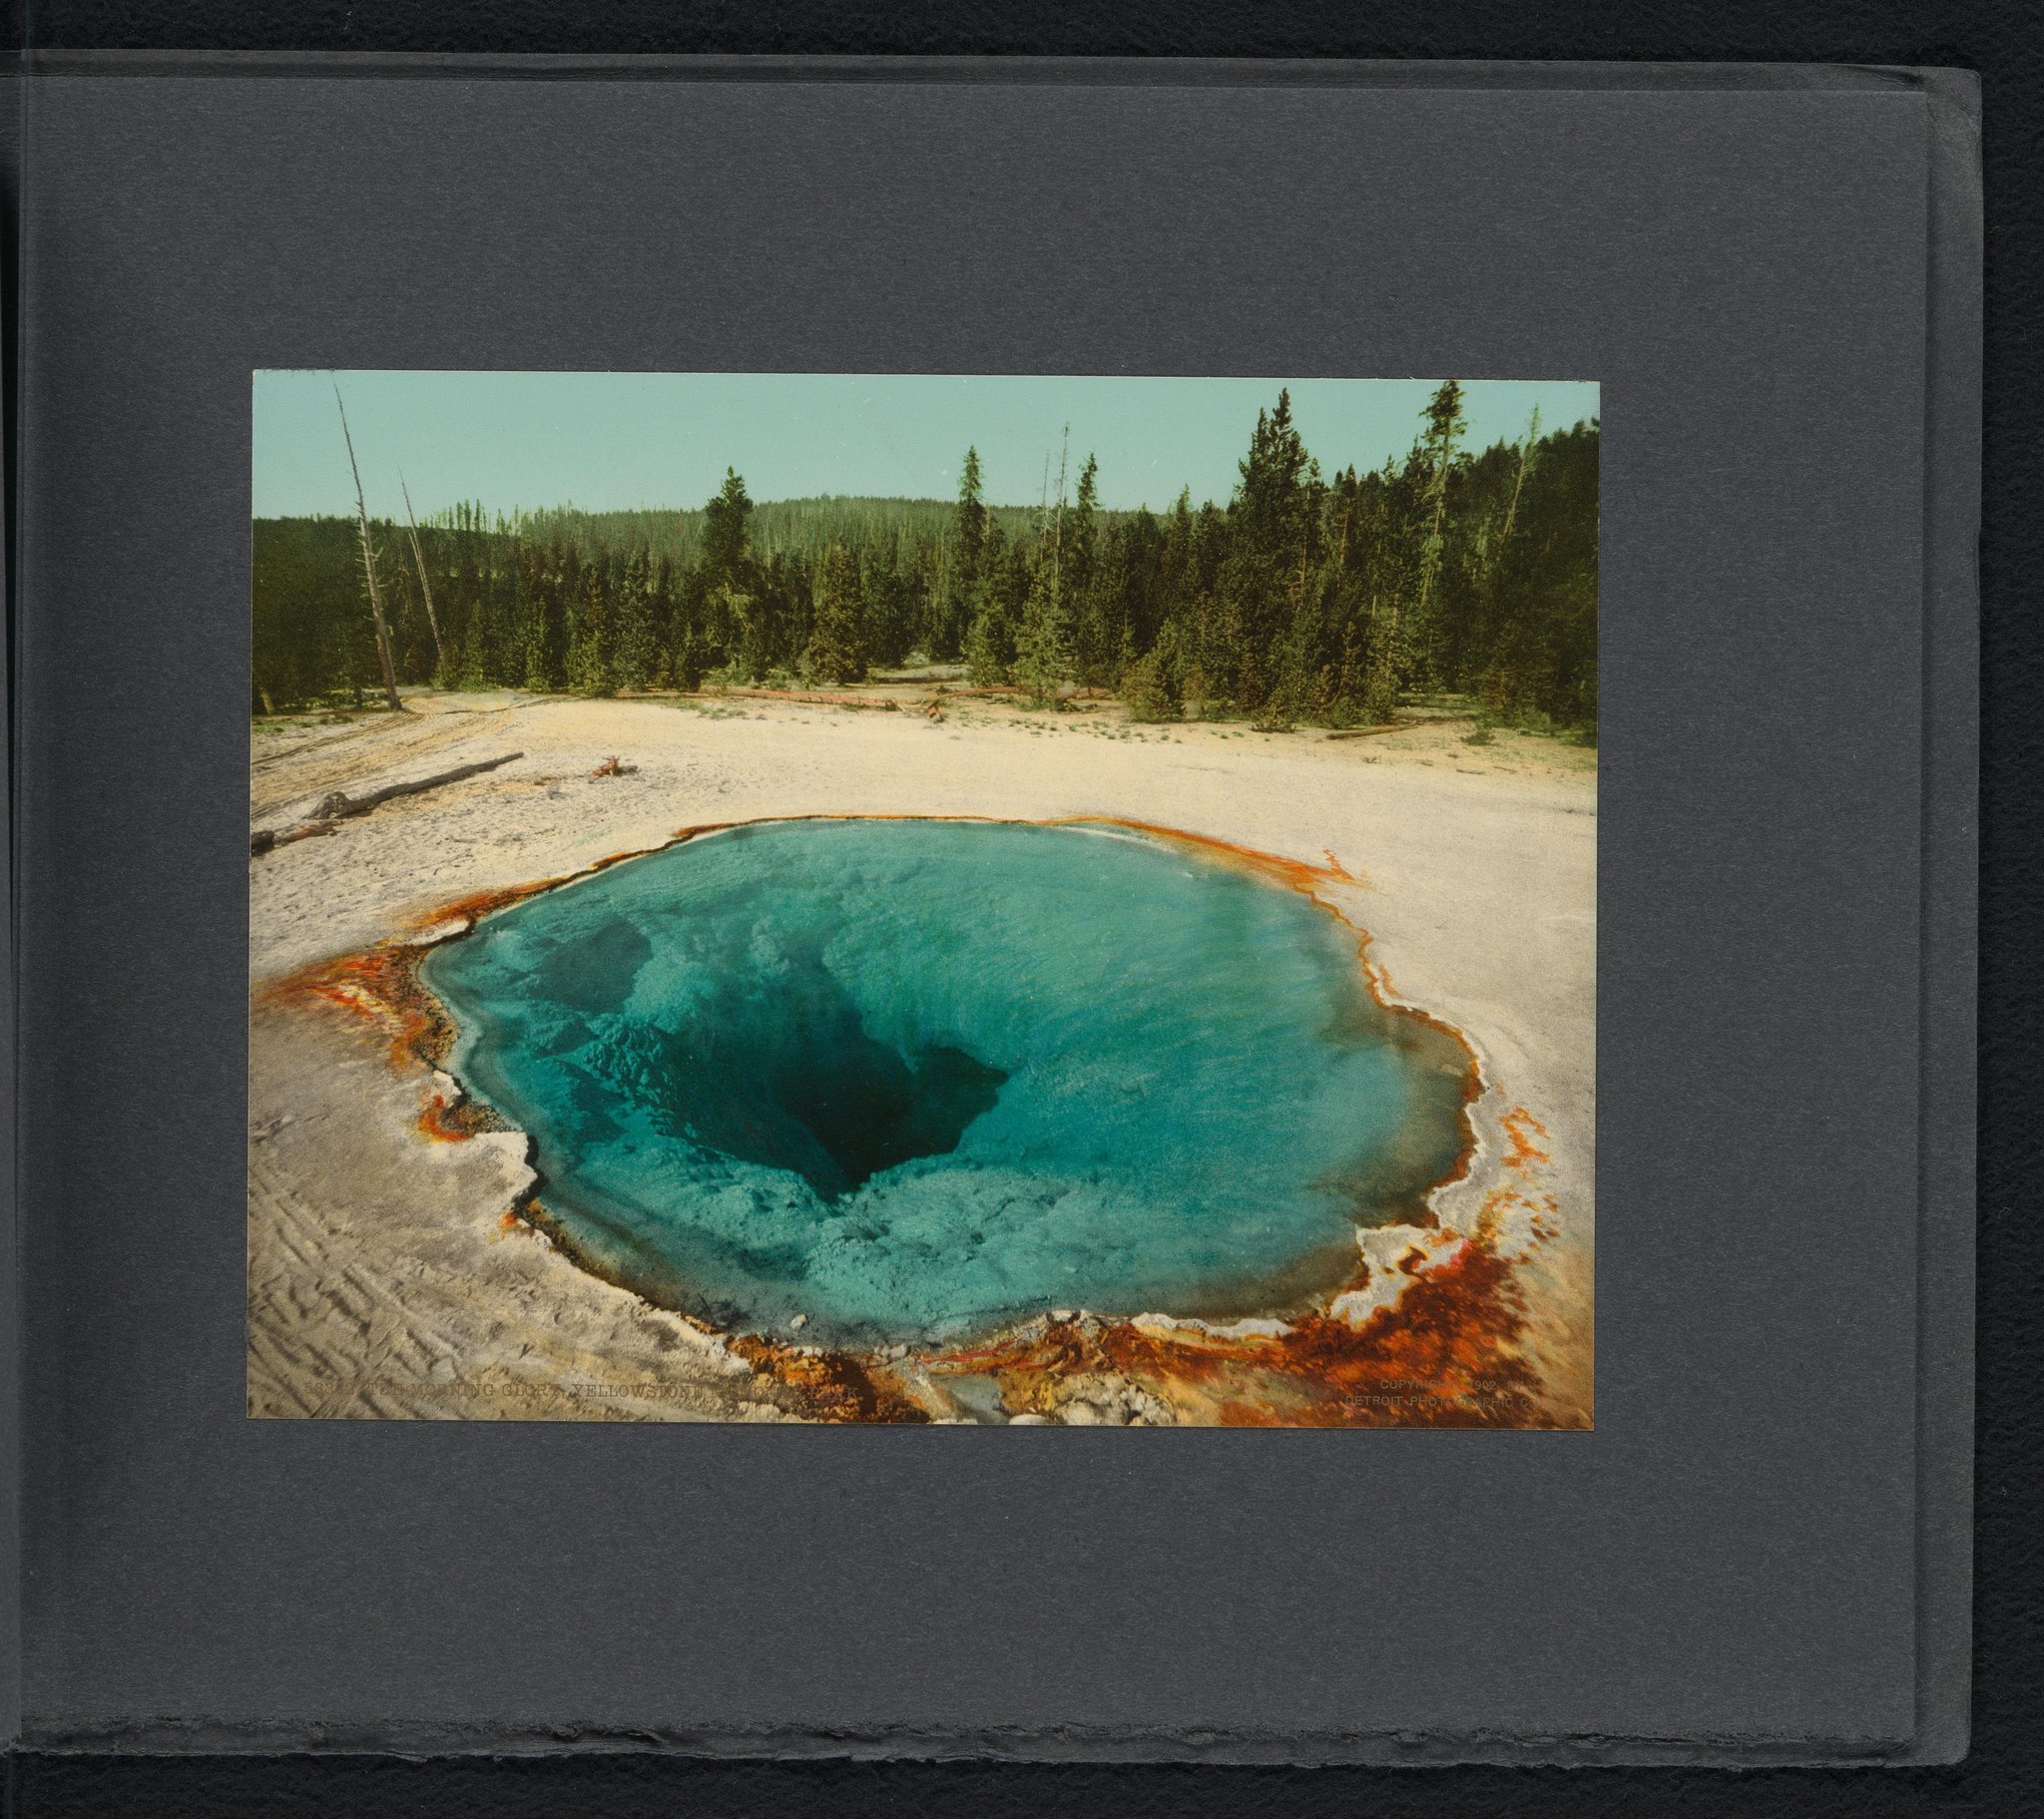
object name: page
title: Gezicht op de Morning Glory Pool in Yellowstone National Park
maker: william henry jackson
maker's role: fotograaf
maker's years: 1843-1942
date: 1902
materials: paper, photographic process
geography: detroit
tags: steam, hot spring, geyser, trees: pine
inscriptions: inscription: ‘53332/ COPYRIGHT, 1902, BY/ DETROIT PHOTOGRAPHIC CO.’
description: Prent op zevenentwintigste ongenummerde pagina.